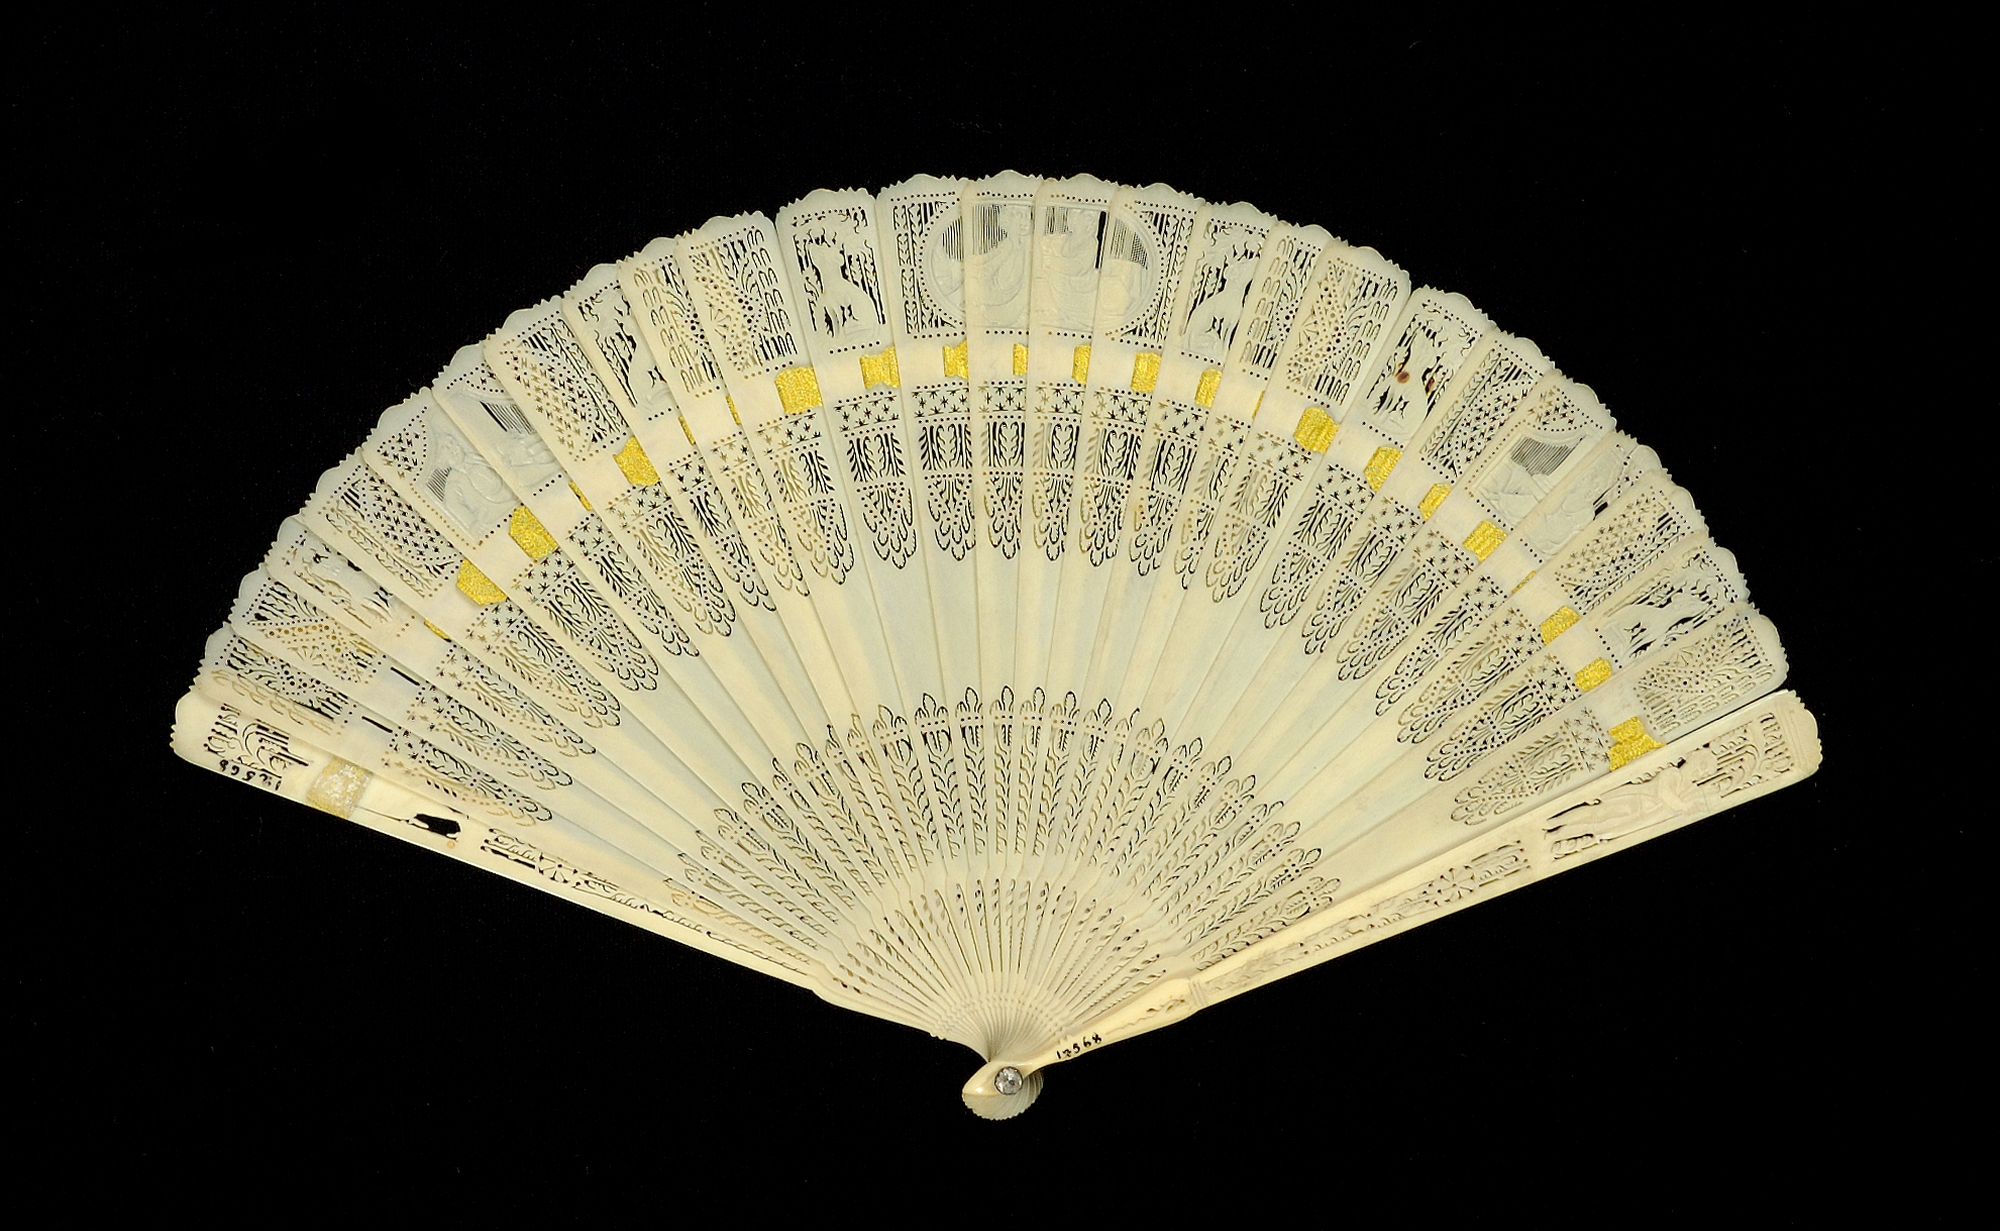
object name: brisé fan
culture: italian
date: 1800-1820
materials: bone, silk